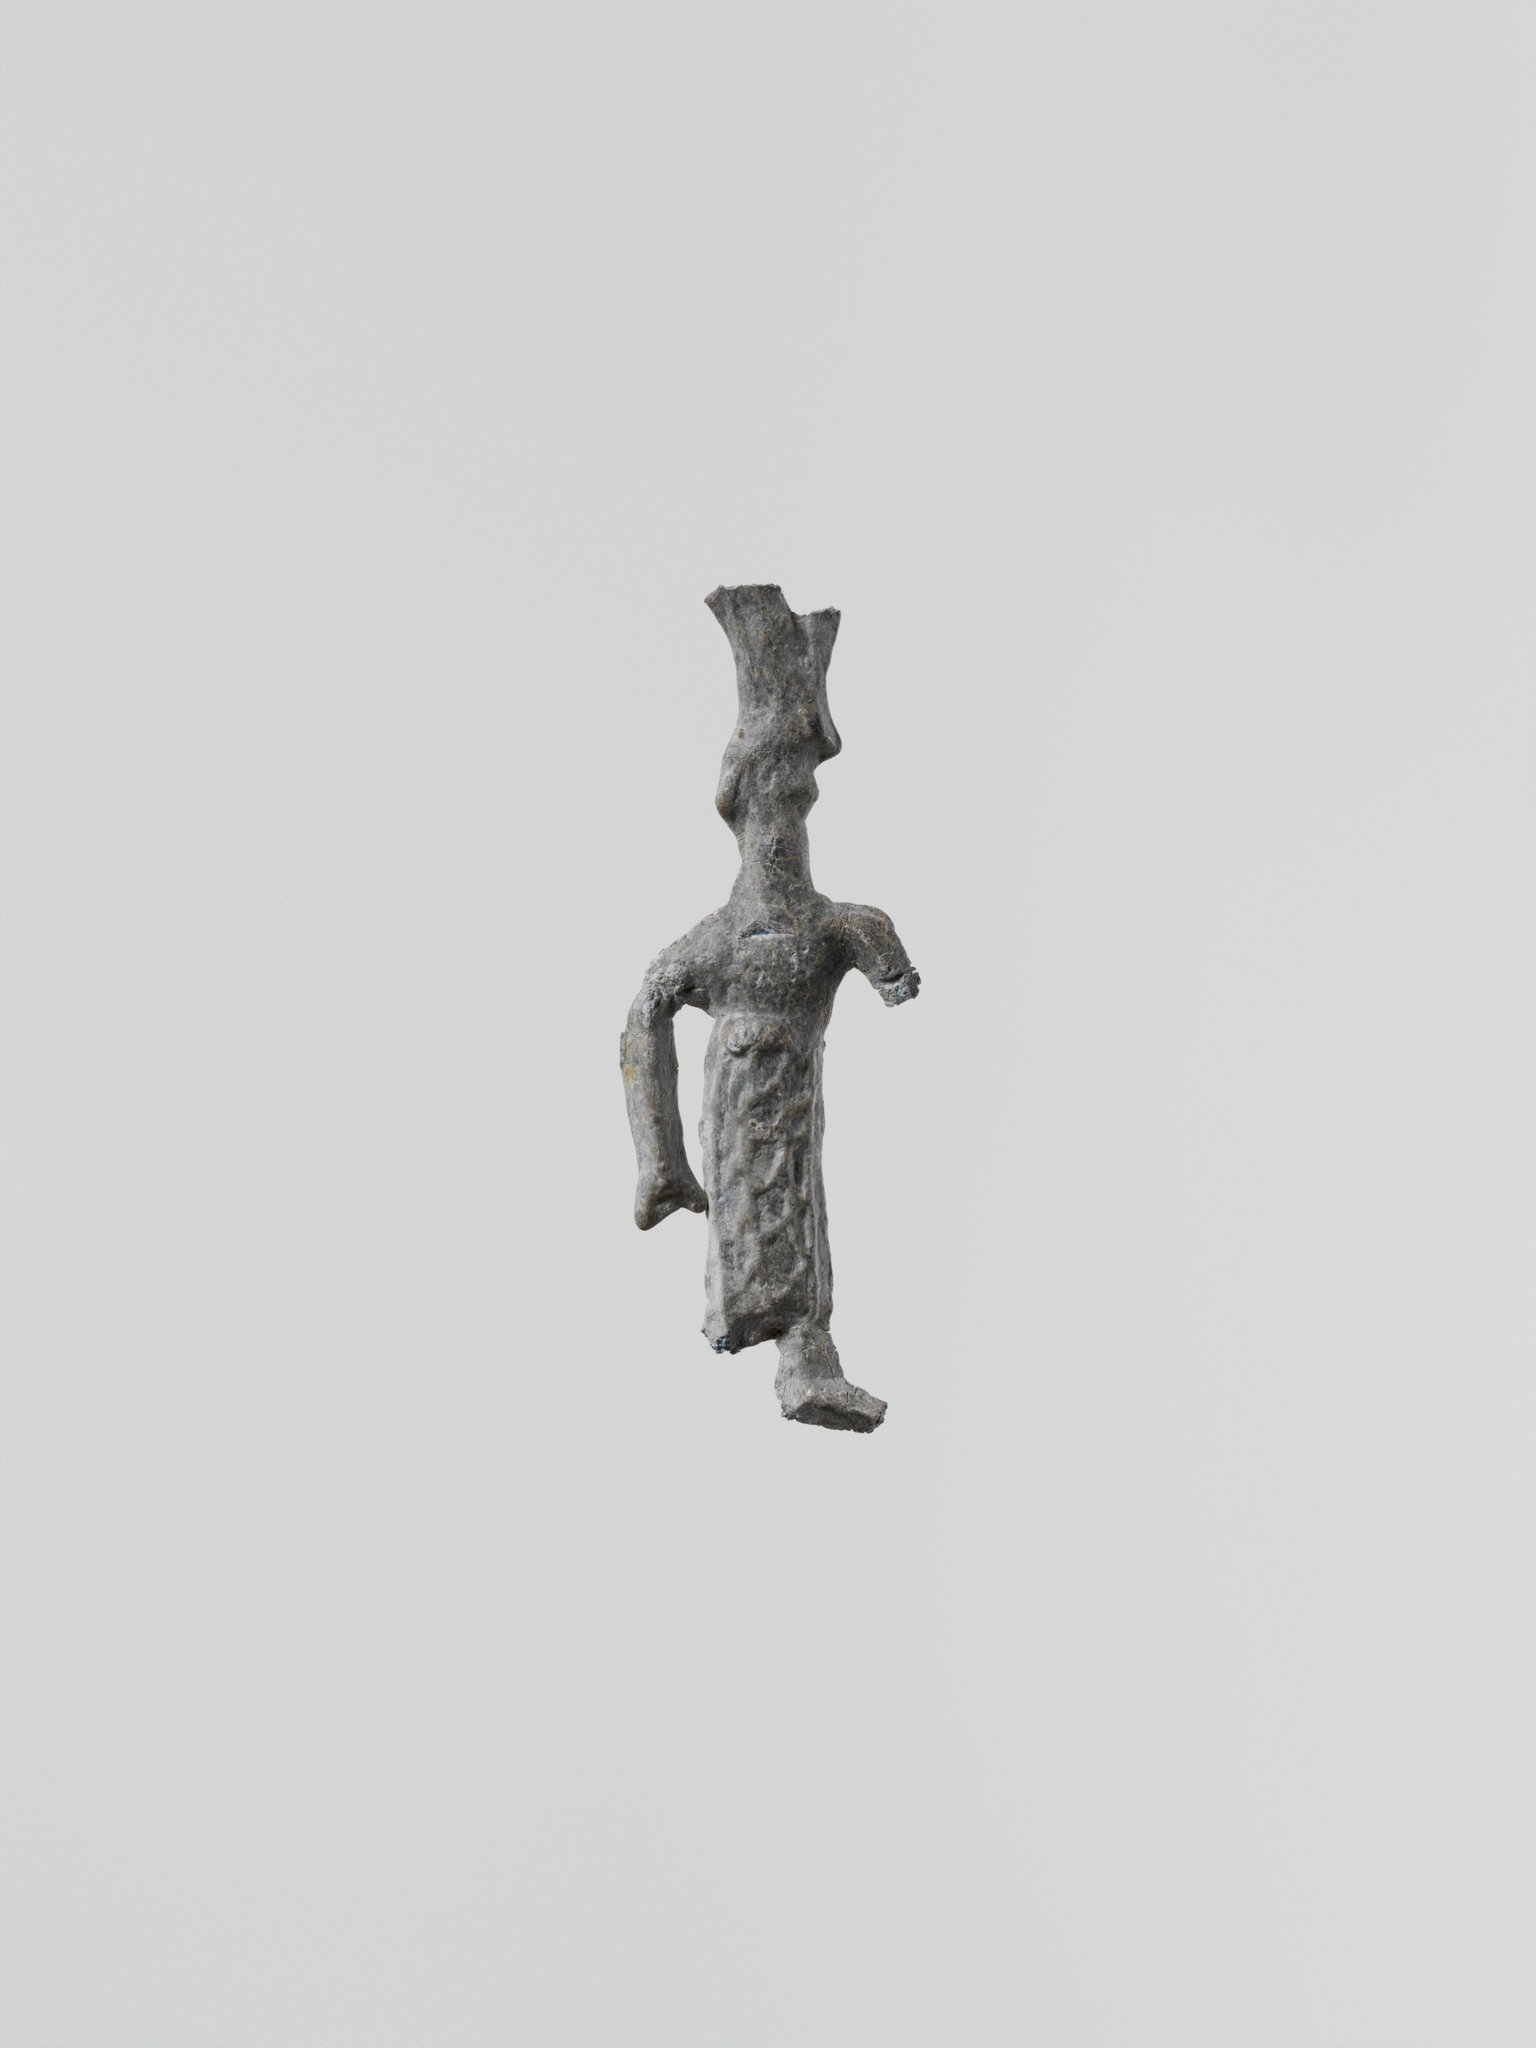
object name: statuette of a woman votary, 5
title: Statuette of a woman votary, 5 ?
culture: greek, laconian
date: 700-500 BCE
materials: lead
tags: women